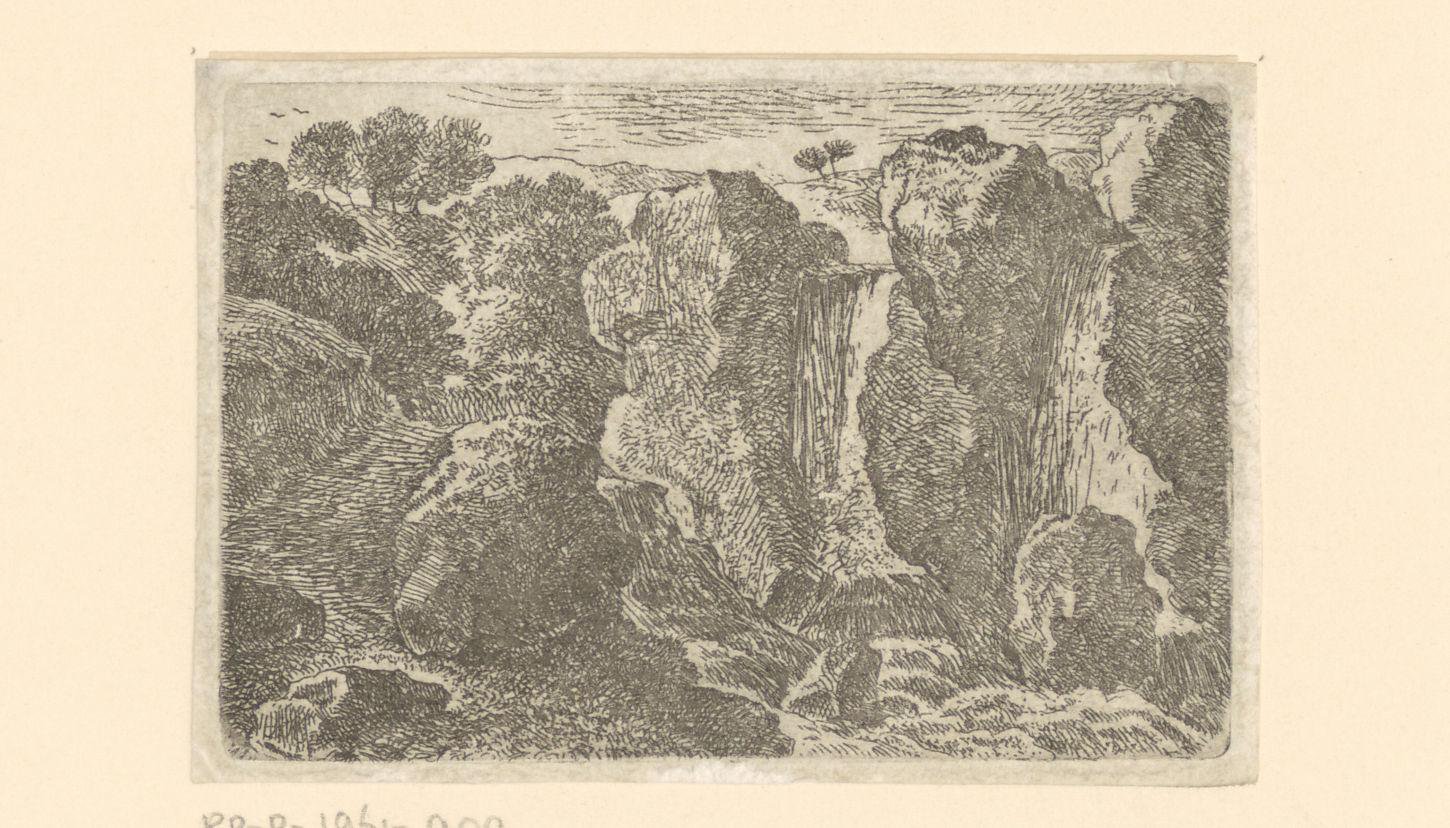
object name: print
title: Landschap met watervallen bij een rotswand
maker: ferdinand kobell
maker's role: artist, painter, print maker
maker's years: 1740-1799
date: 1750-1799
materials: paper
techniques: etching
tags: waterfall, rock-formations